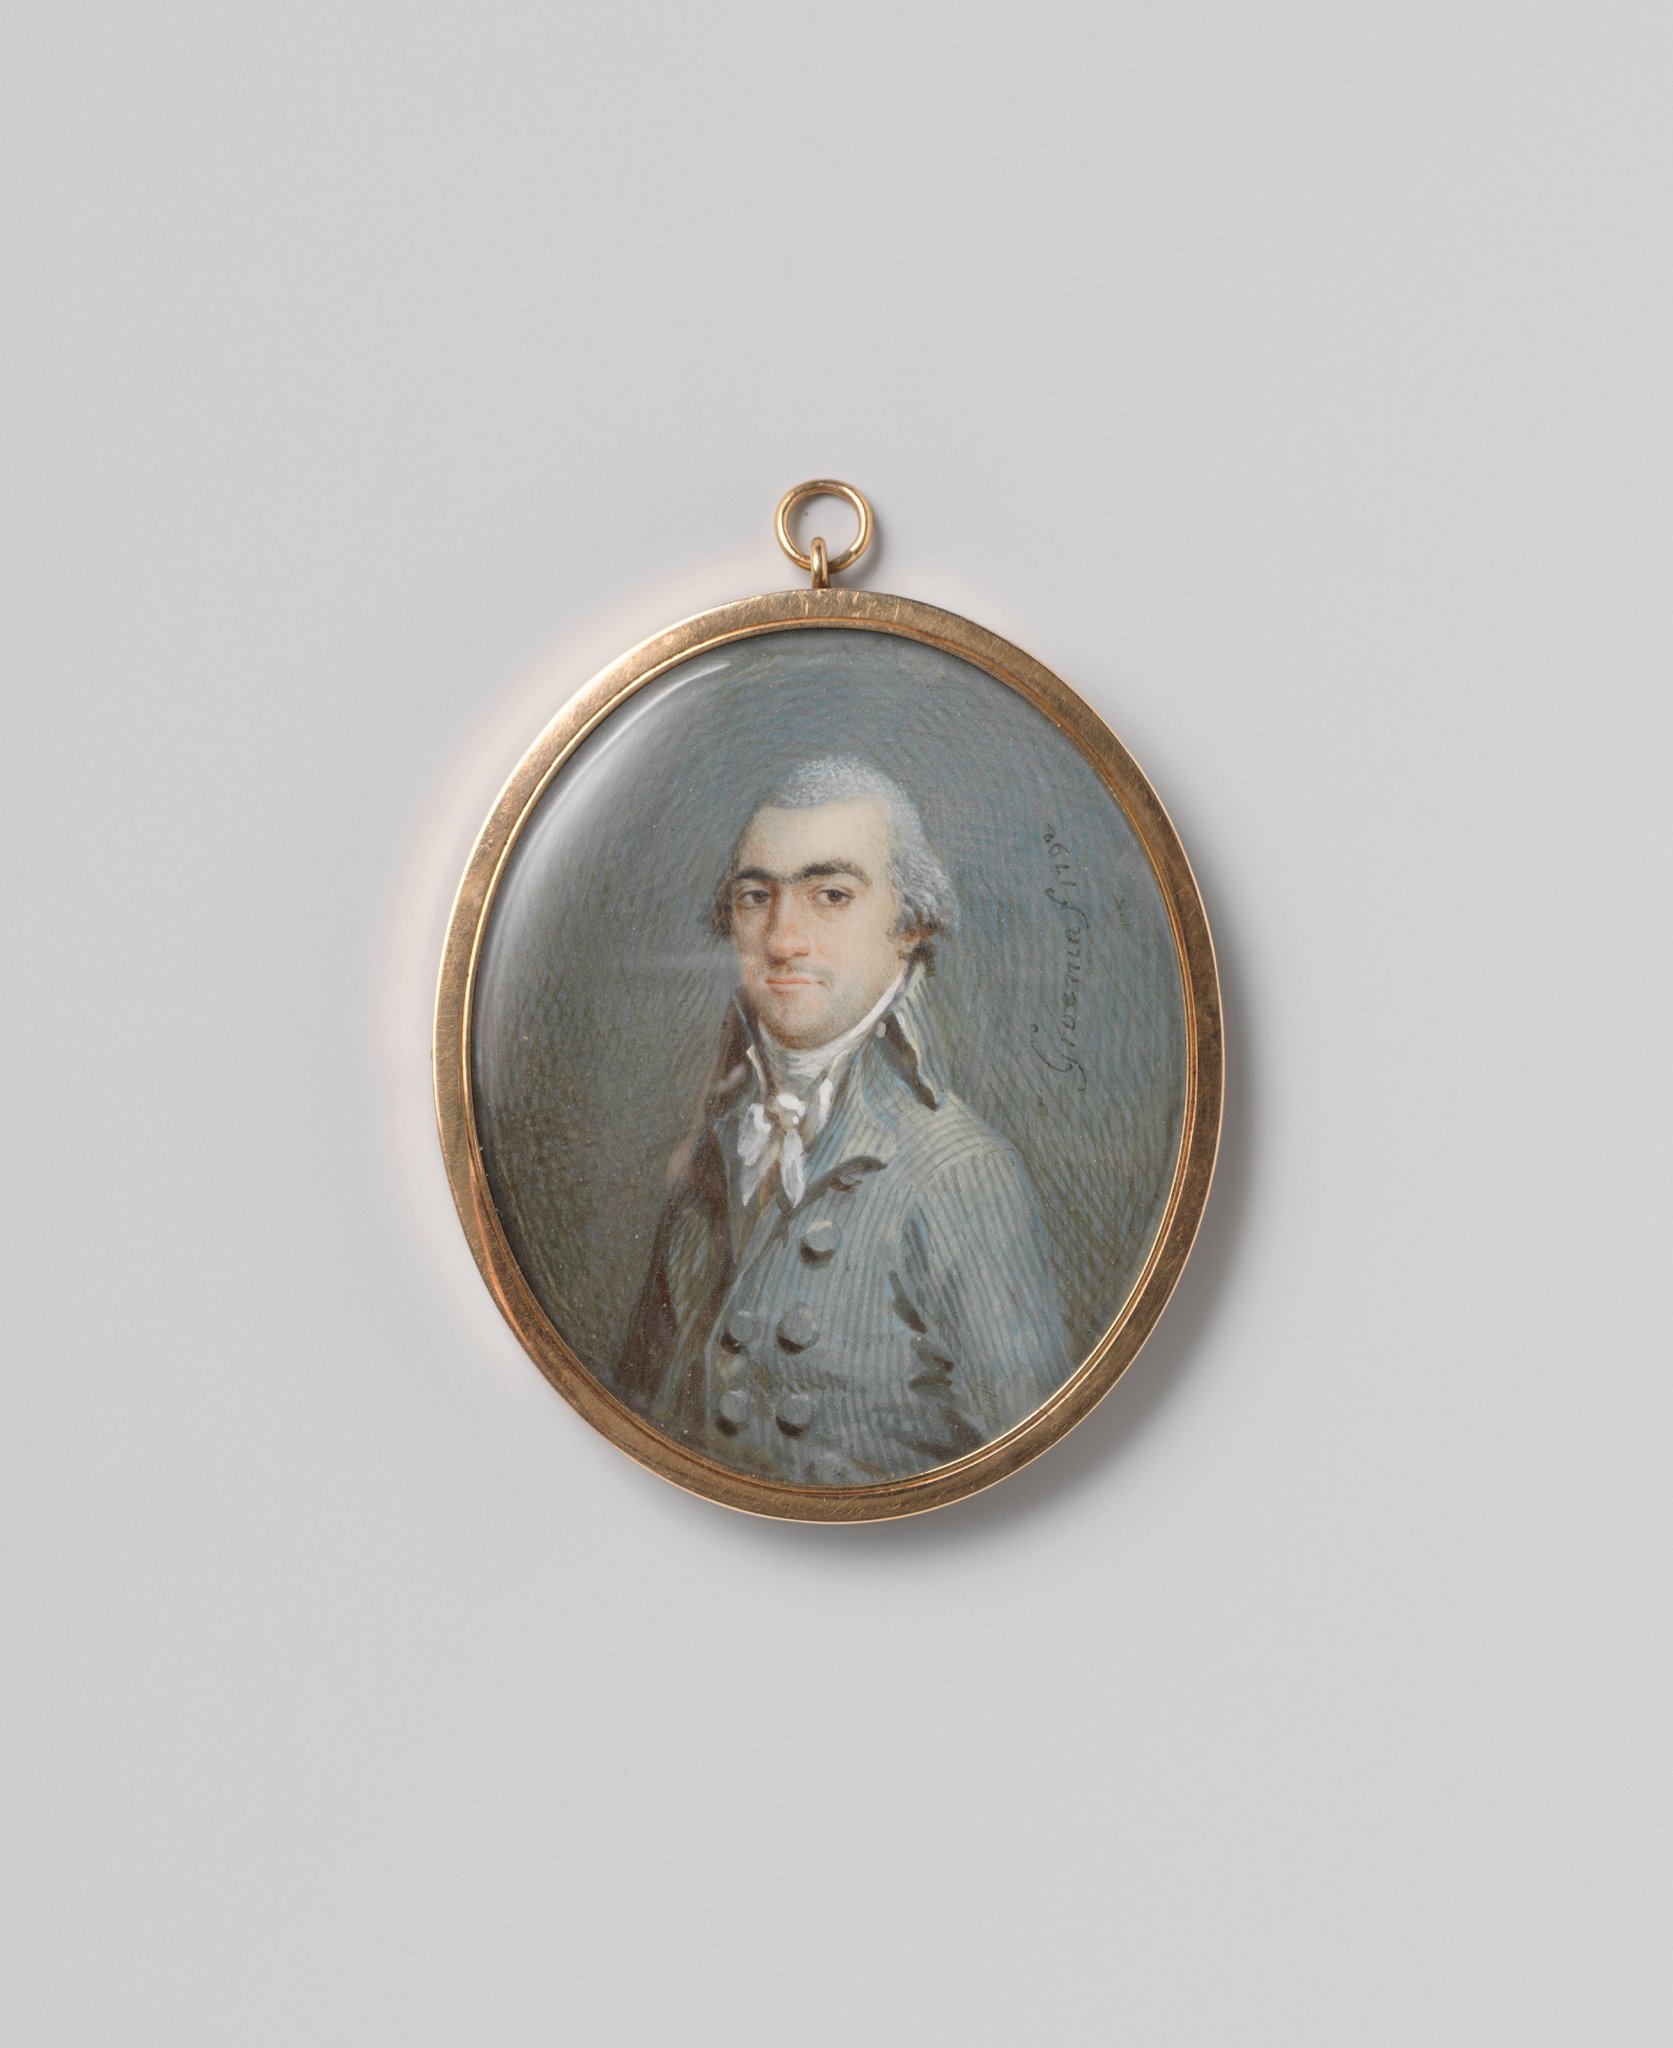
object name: painting, miniature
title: Portret van Herman Willem Daendels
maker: petrus groenia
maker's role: painter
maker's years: 1769-1844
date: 1792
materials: glass, hair, metal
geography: france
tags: herman willem daendels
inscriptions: signature and date: ‘Groenia f 1792’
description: Ovaal portret van Herman Willem Daendels in vergulde lijst en voor- en achterzijde voorzien van glas. Het toont Daendels vlak voor hij zijn militaire carrière in het Franse revolutionaire leger begint. Hij draagt een fraai zijden kostuum en een modieuze gepoederde pruik. Het hoofd is naar rechts gewend. De achterzijde van het portret bestaat uit gevlochten haar.